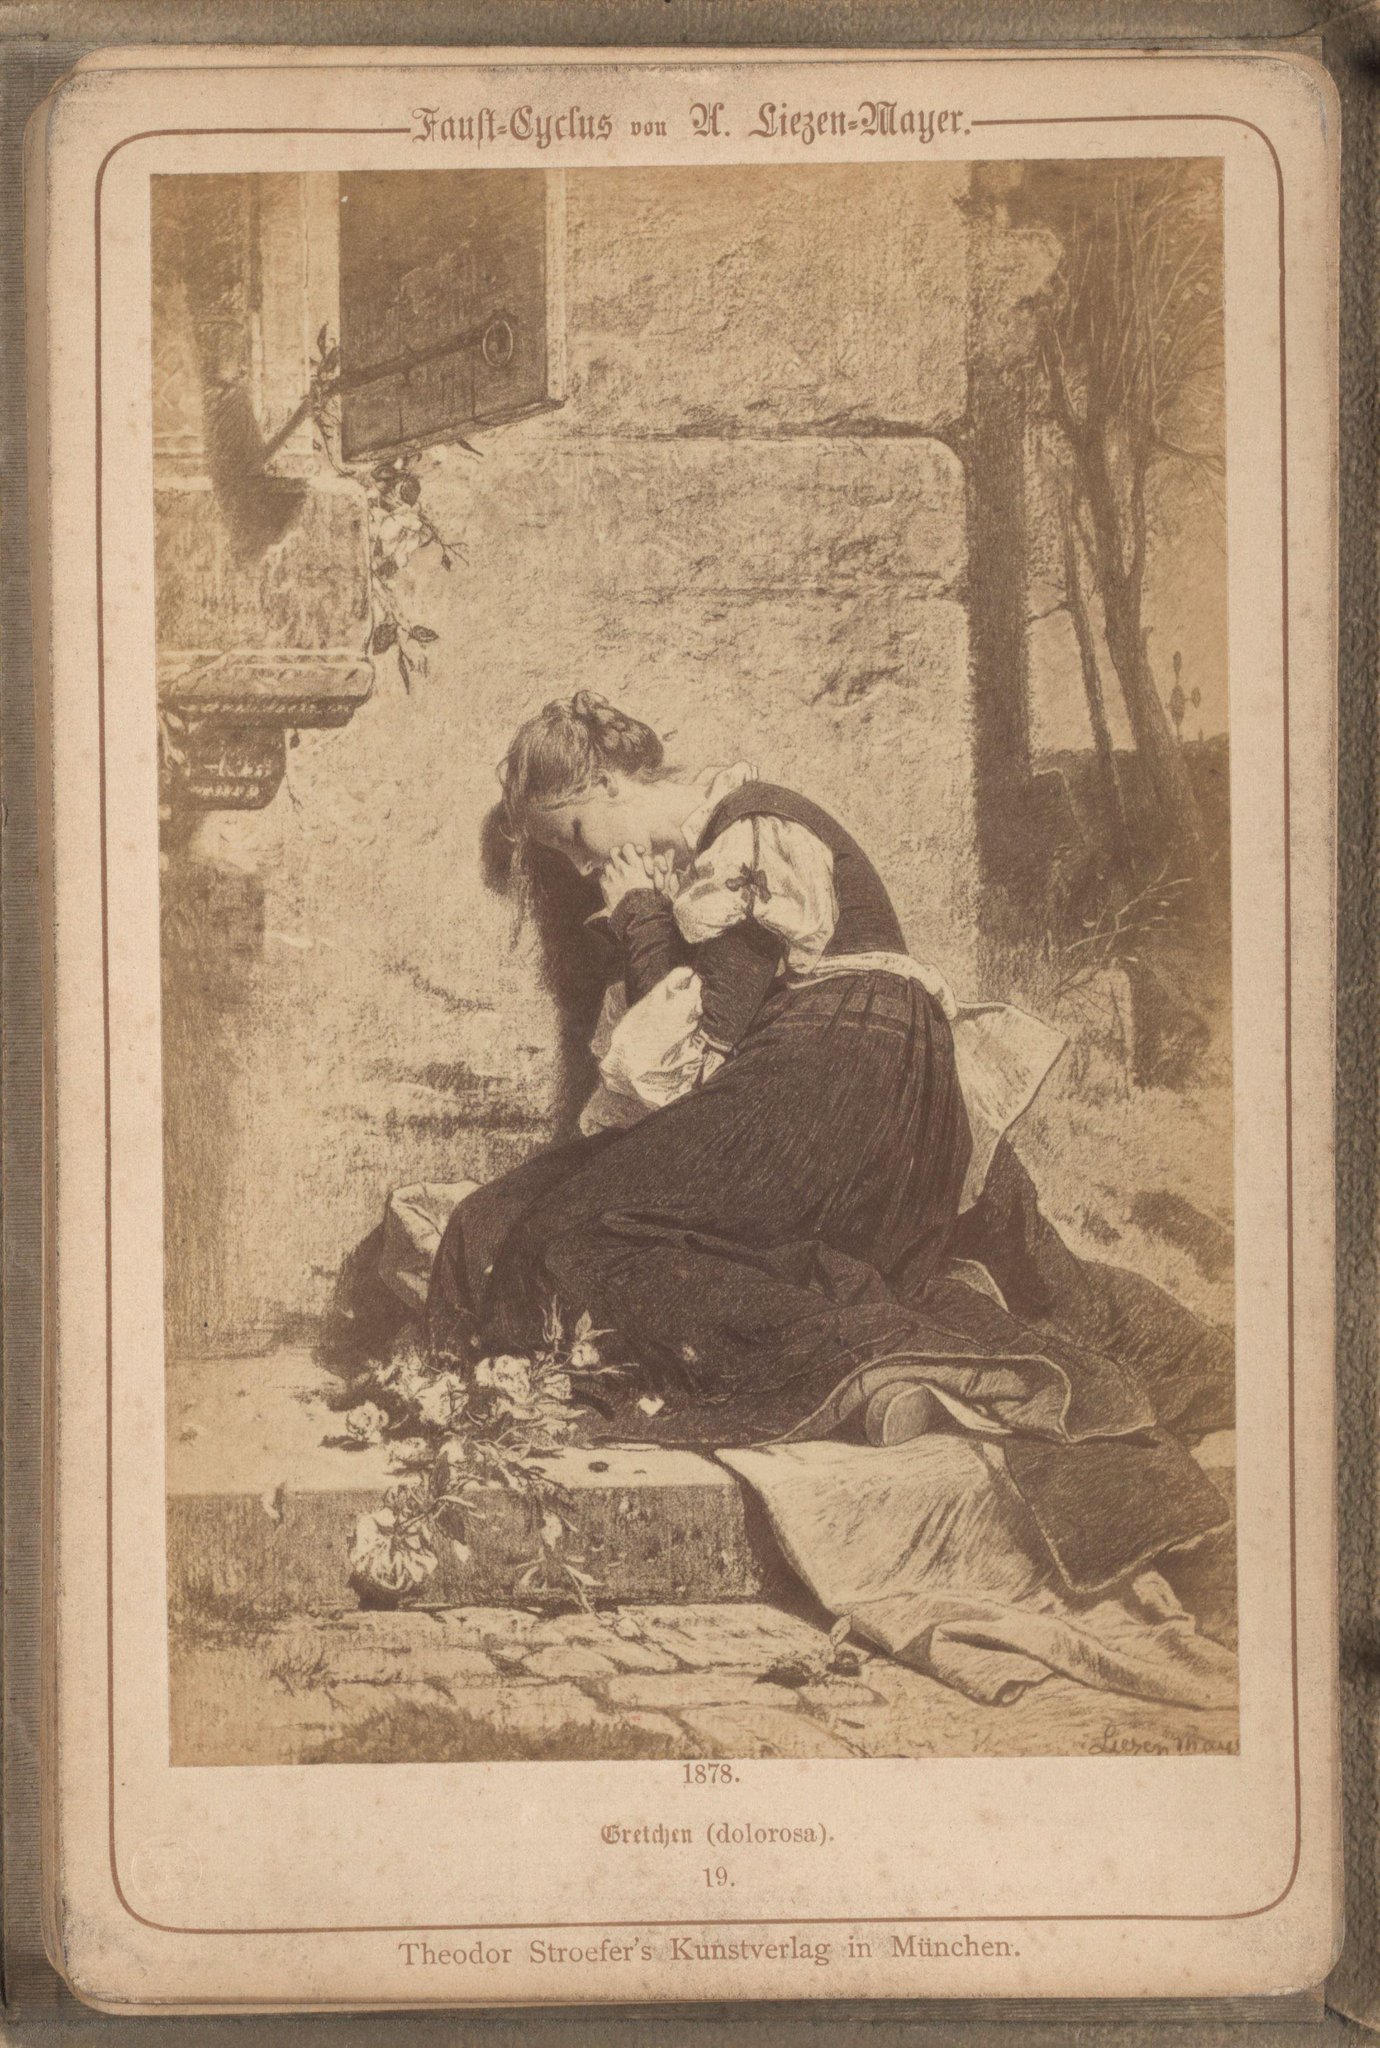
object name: reproduction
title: Gretchen (dolorosa)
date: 1878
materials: cardboard, paper, photographic support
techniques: albumen print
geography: munich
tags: flowers, gretchen, faust, weeping, pavement, floor ~ architecture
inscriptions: number: ‘19’, check stamp: ‘TS’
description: Onderdeel van Album met 30 fotoreproducties van tekeningen van het Faust-verhaal van J.W. von Goethe.